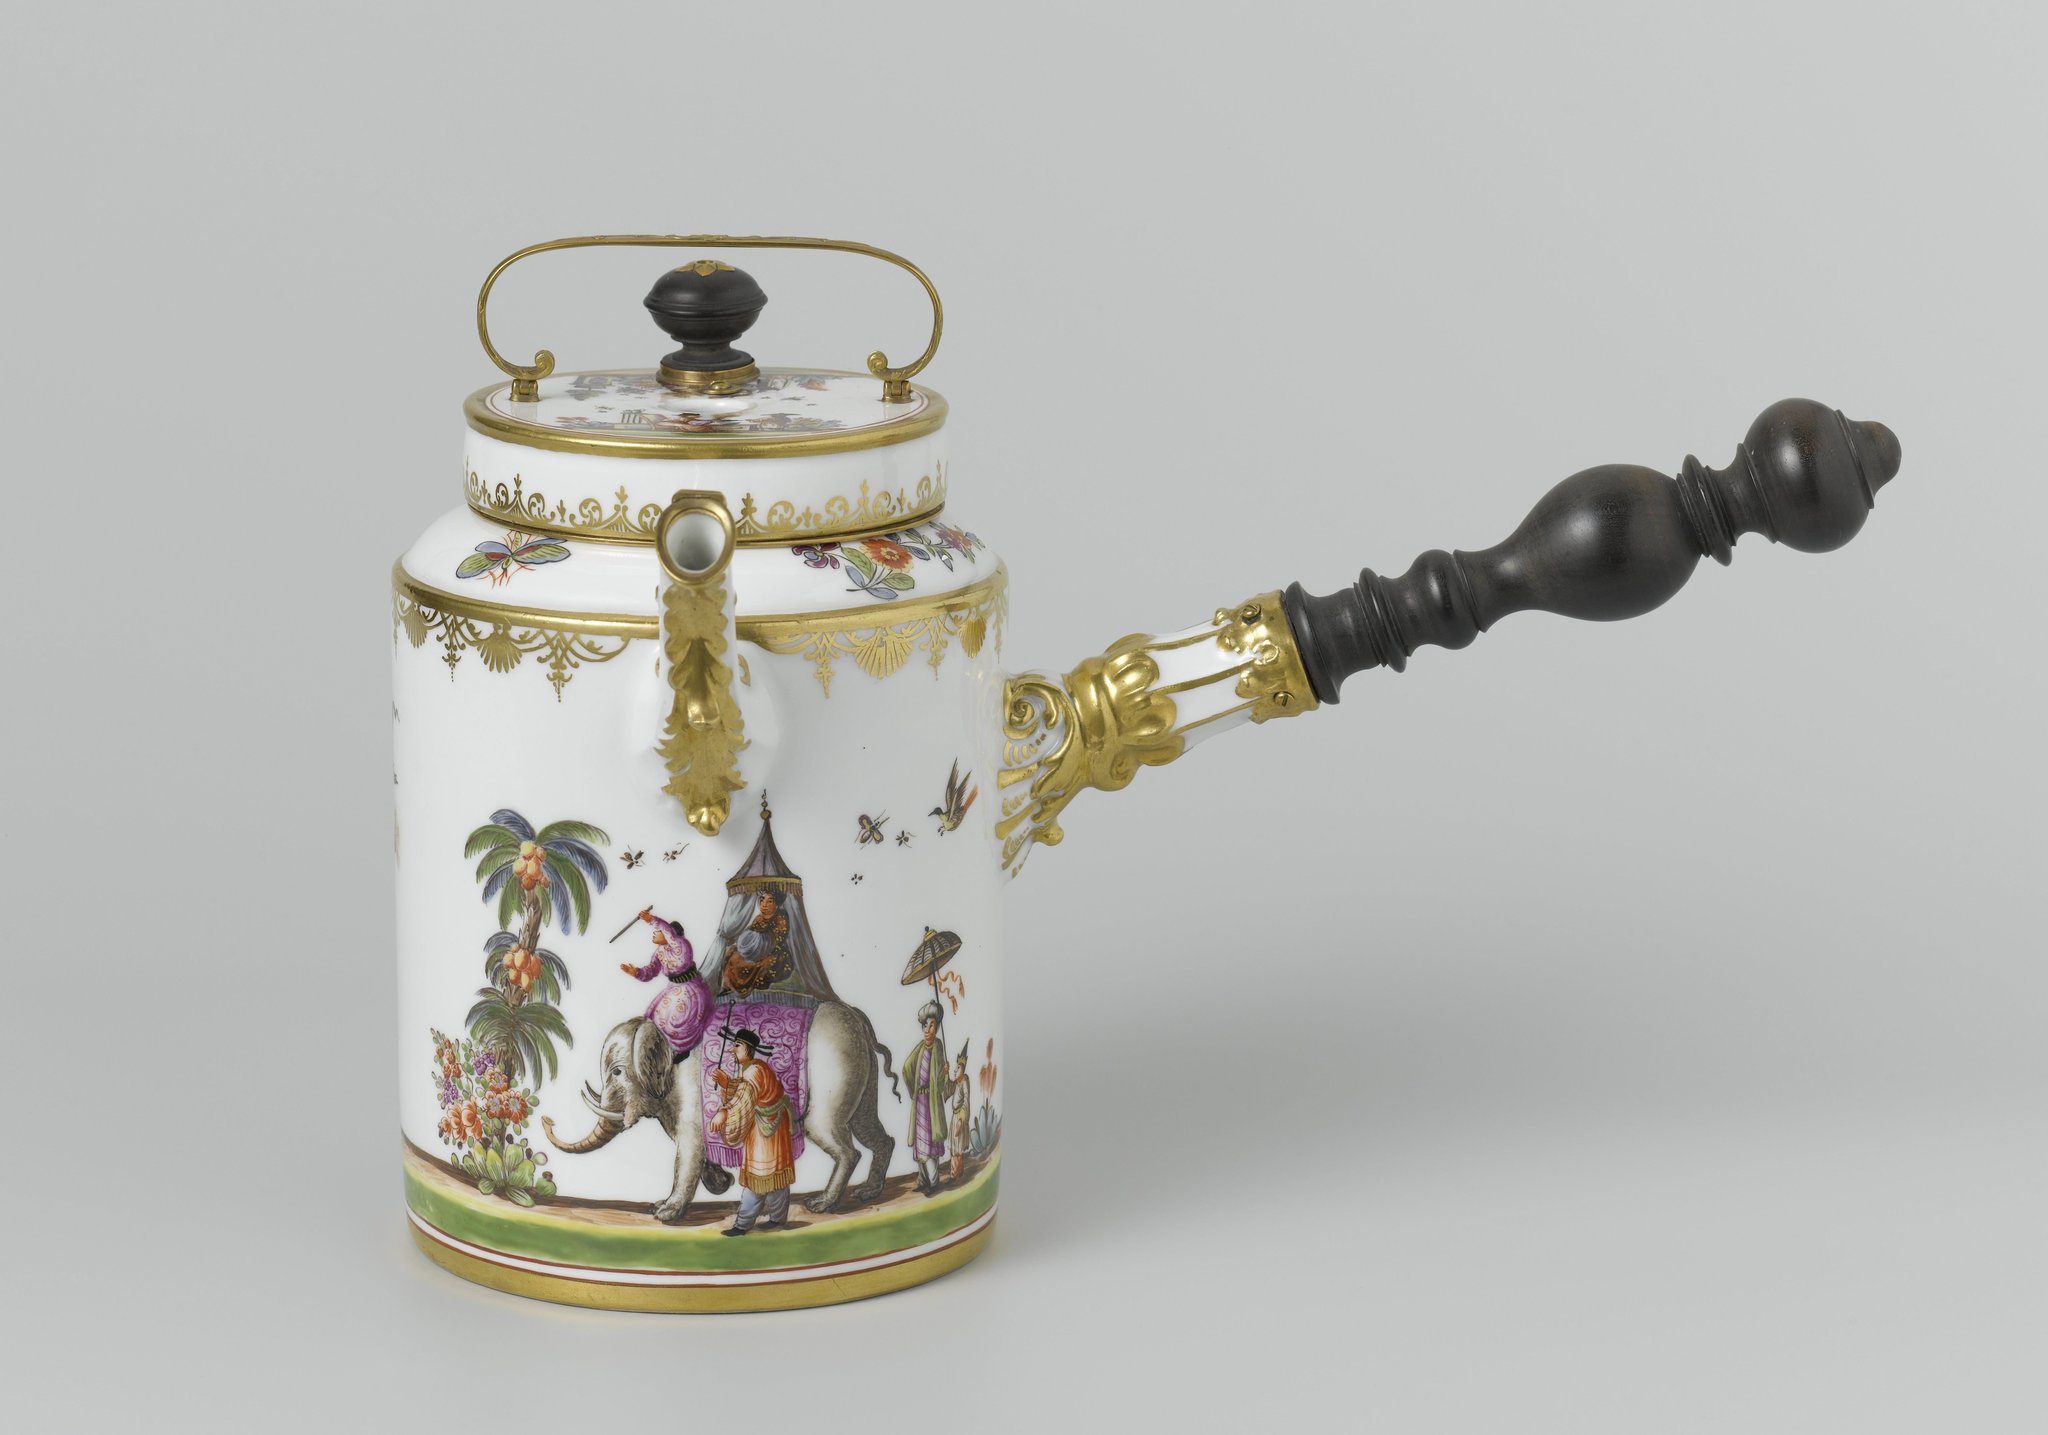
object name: eating drinking utensil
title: Chocolate pot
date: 1735-1740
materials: wood, porcelain, silver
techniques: gilding, painted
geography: meissen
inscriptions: mark, factory mark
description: Meissener Porzellan Manufaktur Meissen, c. 1735–1740 hard-paste porcelain, silver gilt, ebony